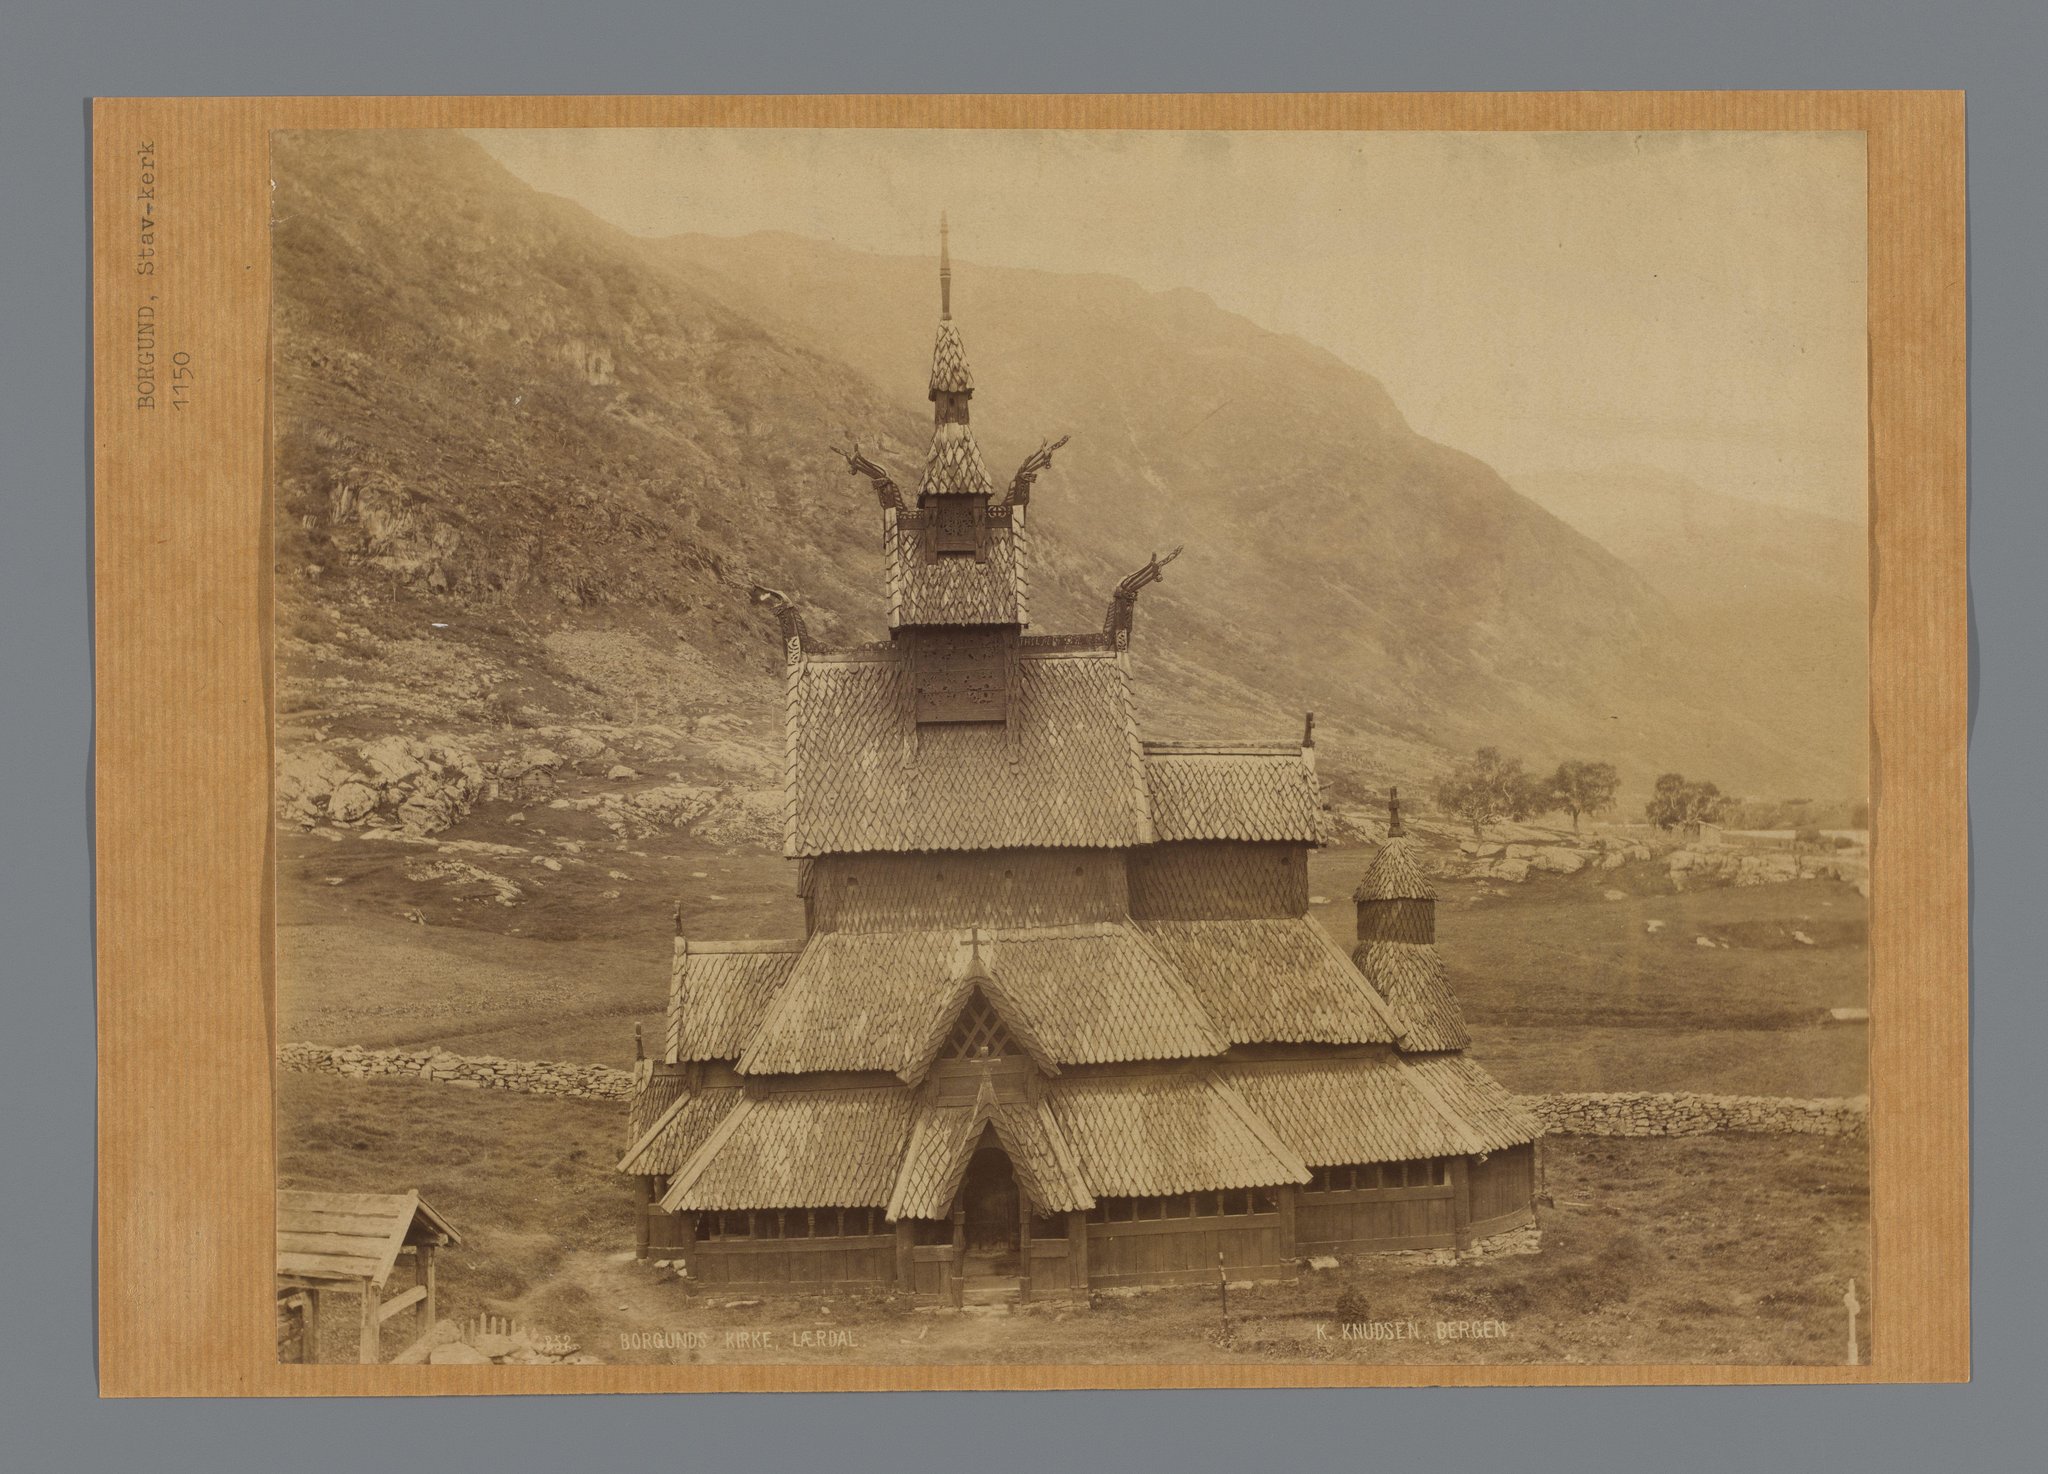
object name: photograph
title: Stav-kerk. Brogund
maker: Anonymous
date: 1850-1900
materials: photographic support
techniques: albumen print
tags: borgund